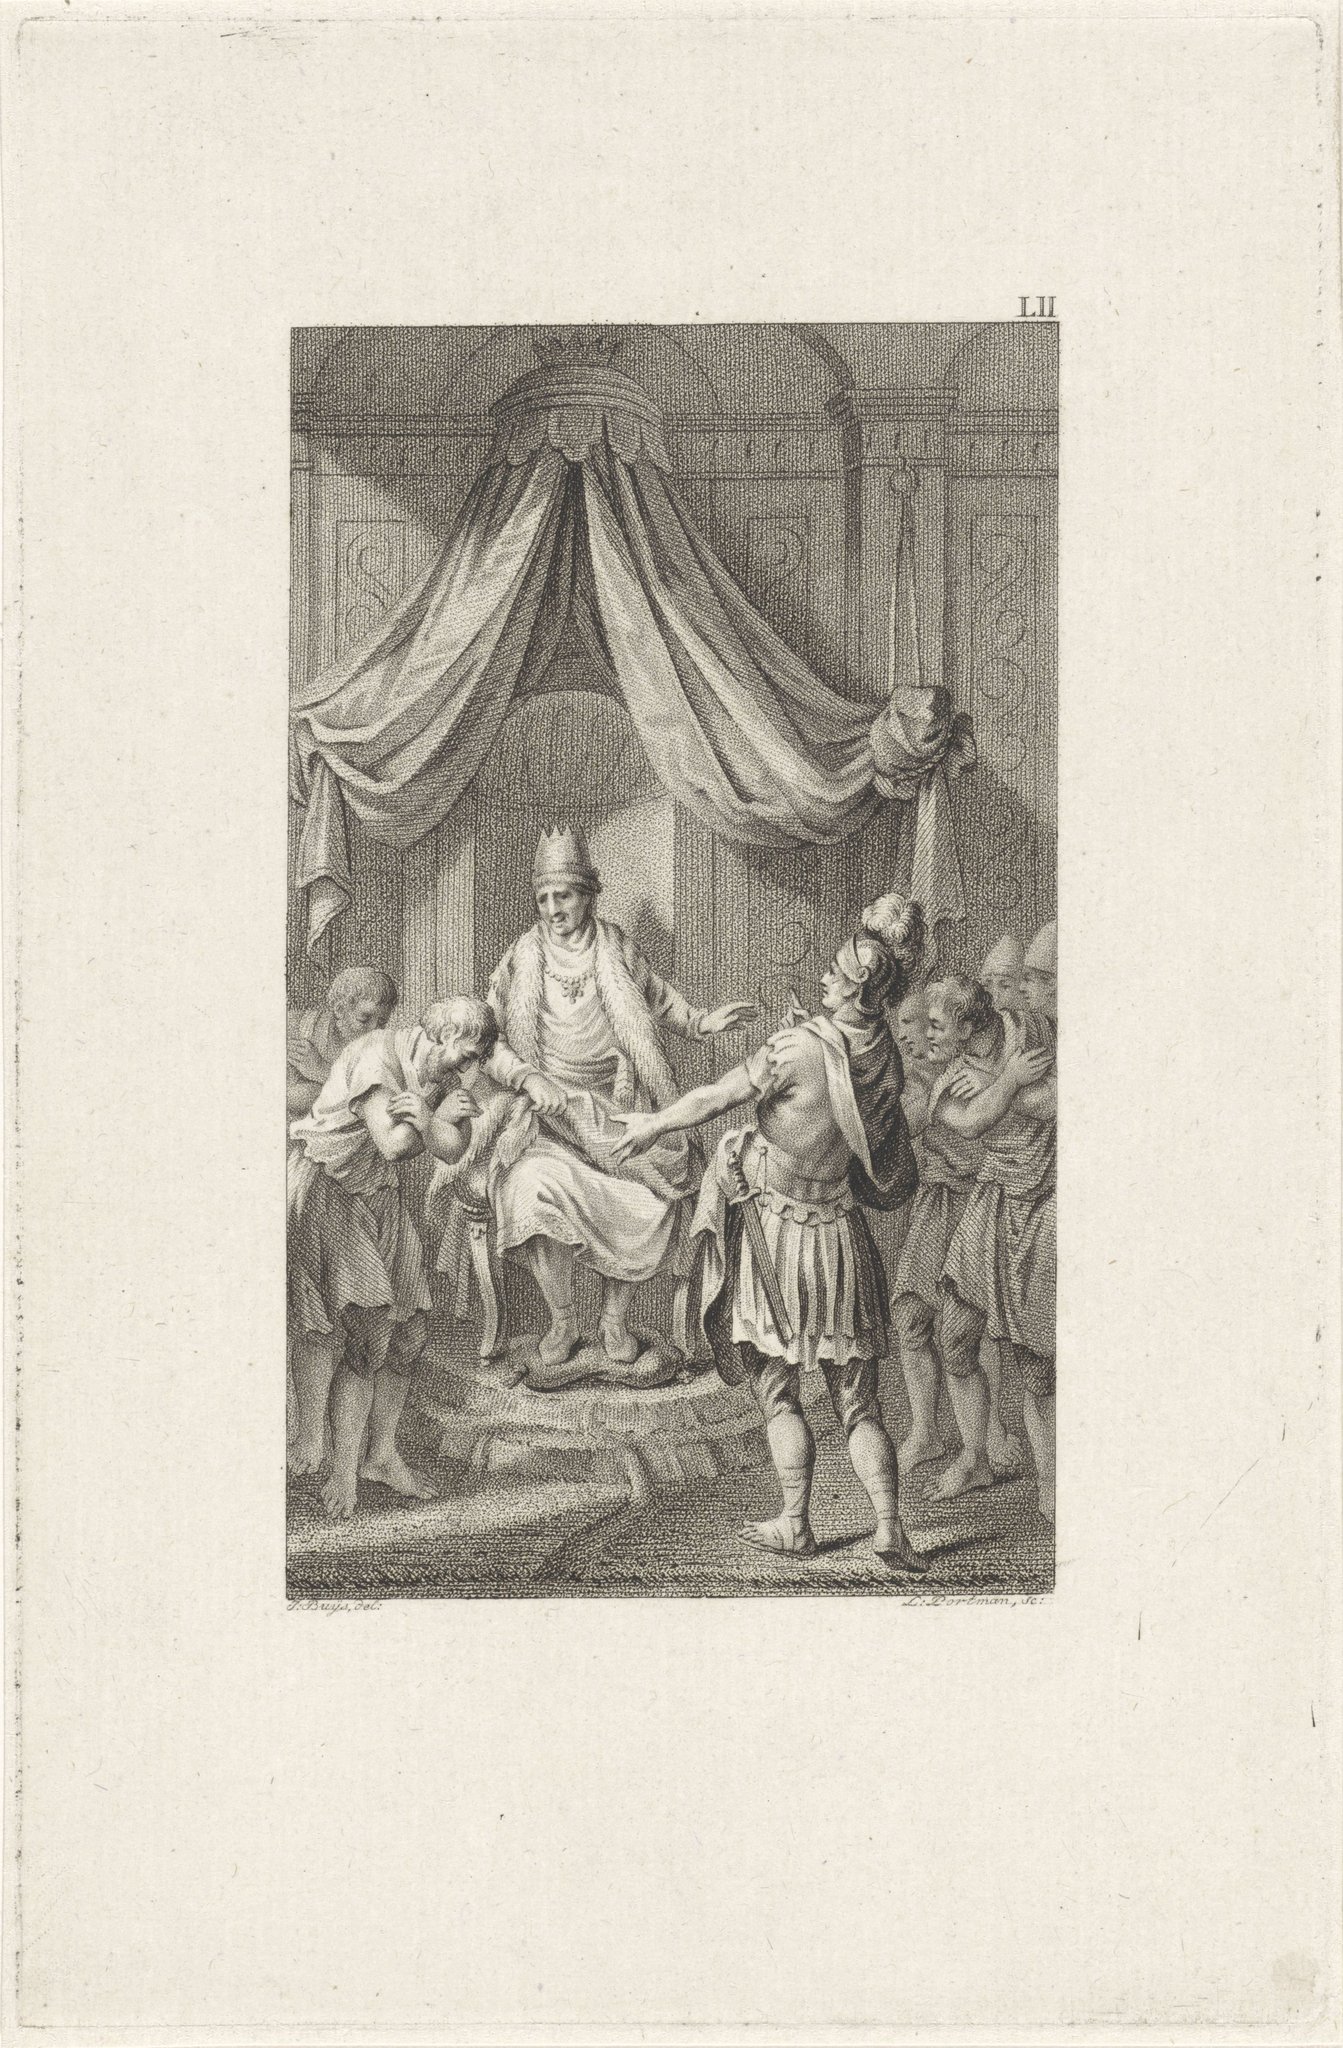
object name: print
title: Gezant van Appius Claudius Caecus aan het hof van Tigranes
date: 1799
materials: paper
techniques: etching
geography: amsterdam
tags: non-aggressive activities of appius claudius caecus, male persons from classical history (tigranes)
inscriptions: collector's mark: Lugt 2228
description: Koning Tigranes dwingt zijn bedienden om blootvoets en in onderkleding, met gekruiste armen, voor zijn troon te staan, als hij aan vreemde gezanten audiëntie verleent.